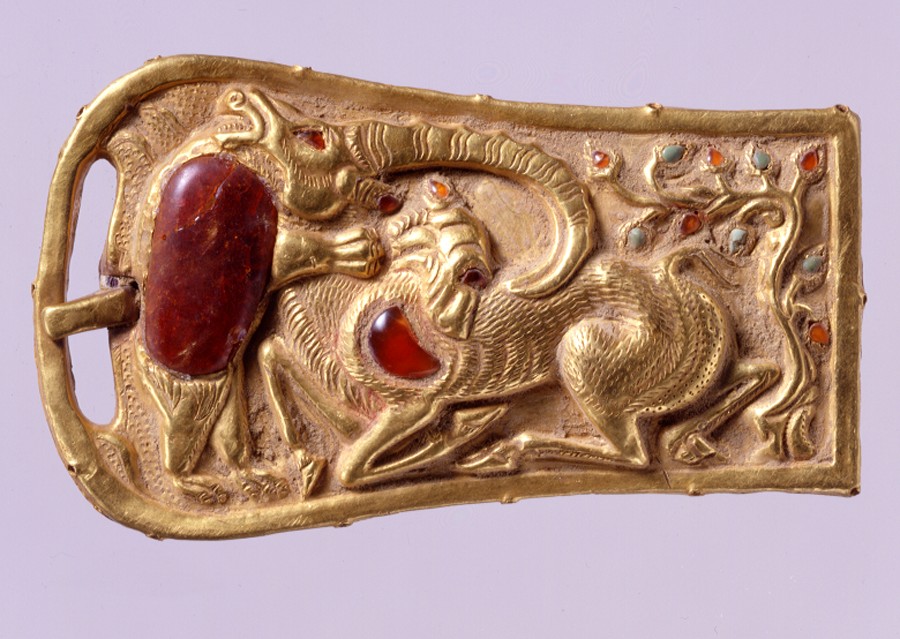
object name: buckle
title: Belt Buckle with Ibex and Bear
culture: chinese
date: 100 BCE-100 CE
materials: amber, gemstone, gold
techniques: inlay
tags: bears,ibex